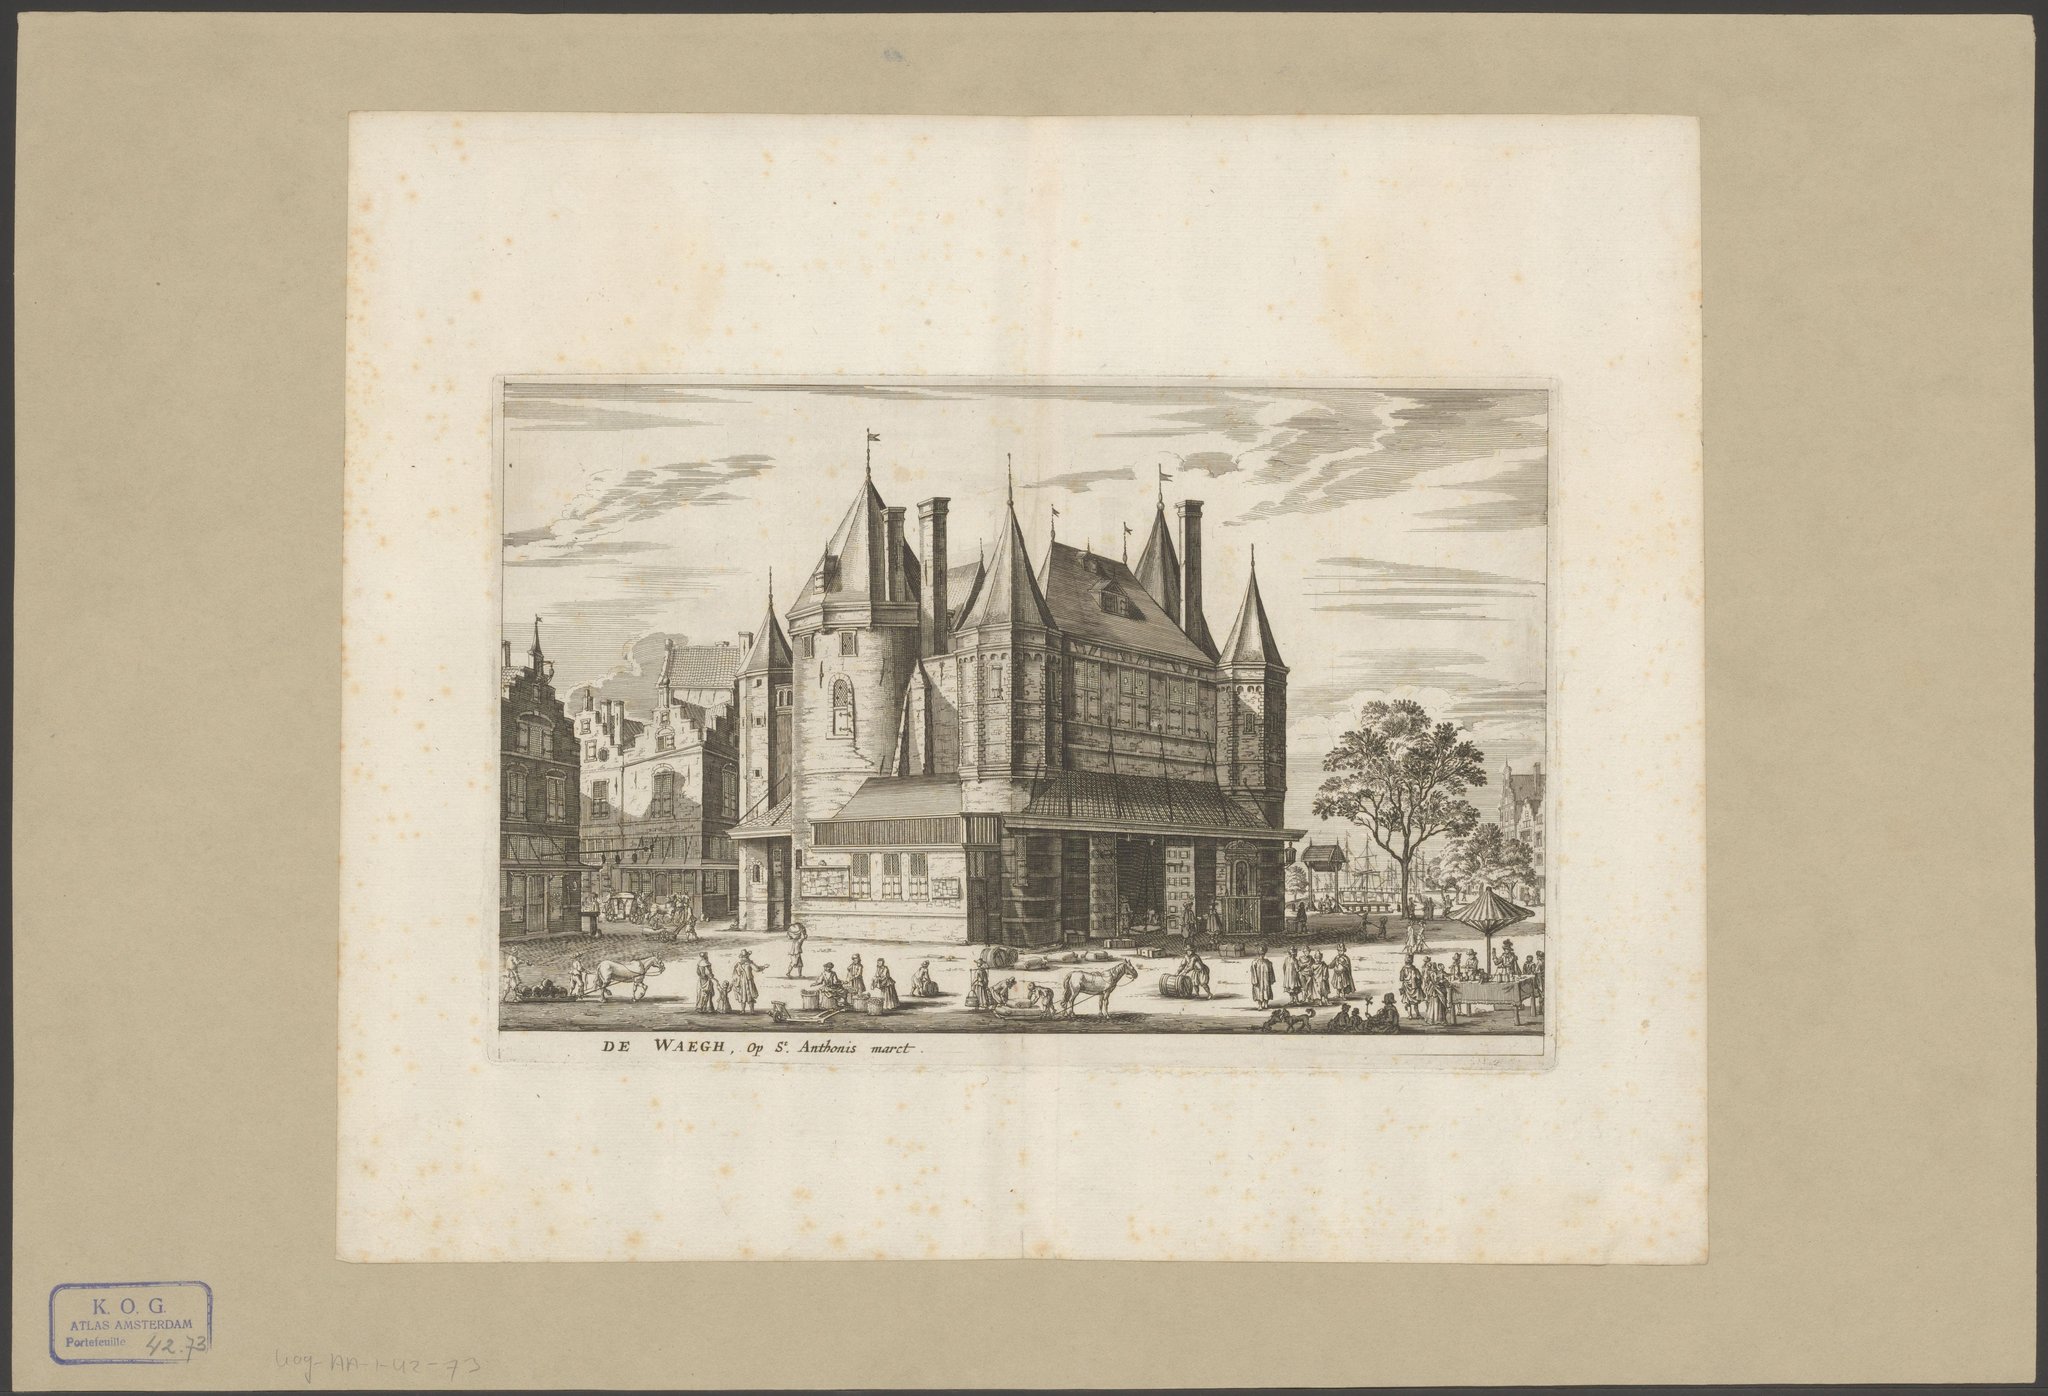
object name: print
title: Gezicht op de Waag op de Nieuwmarkt te Amsterdam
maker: jacob van meurs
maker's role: draughtsman, print maker, publisher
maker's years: 1619-1680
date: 1663-1664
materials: paper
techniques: engraving, etching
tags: weigh-house, amsterdam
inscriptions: collector's mark: Lugt 1641b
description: Gezicht op de Waag op de Nieuwmarkt (Sint-Antoniesmarkt), ook wel bekend als de Sint-Antonieswaag, te Amsterdam. Deze waag was gevestigd in de voormalige Eerste Sint-Antoniespoort. Dit vijftiende-eeuwse gebouw kwam na de stadsuitbreidingen uit het einde van de zestiende eeuw binnen de stad te liggen en verloor zo zijn functie als stadspoort. In 1617-1618 werd het ingericht als waag. Voor het gebouw verschillende figuren. Onderwerpsrubriek binnen de Atlas Amsterdam: Markten, handel: C. Veemen, Waaggebouwen.